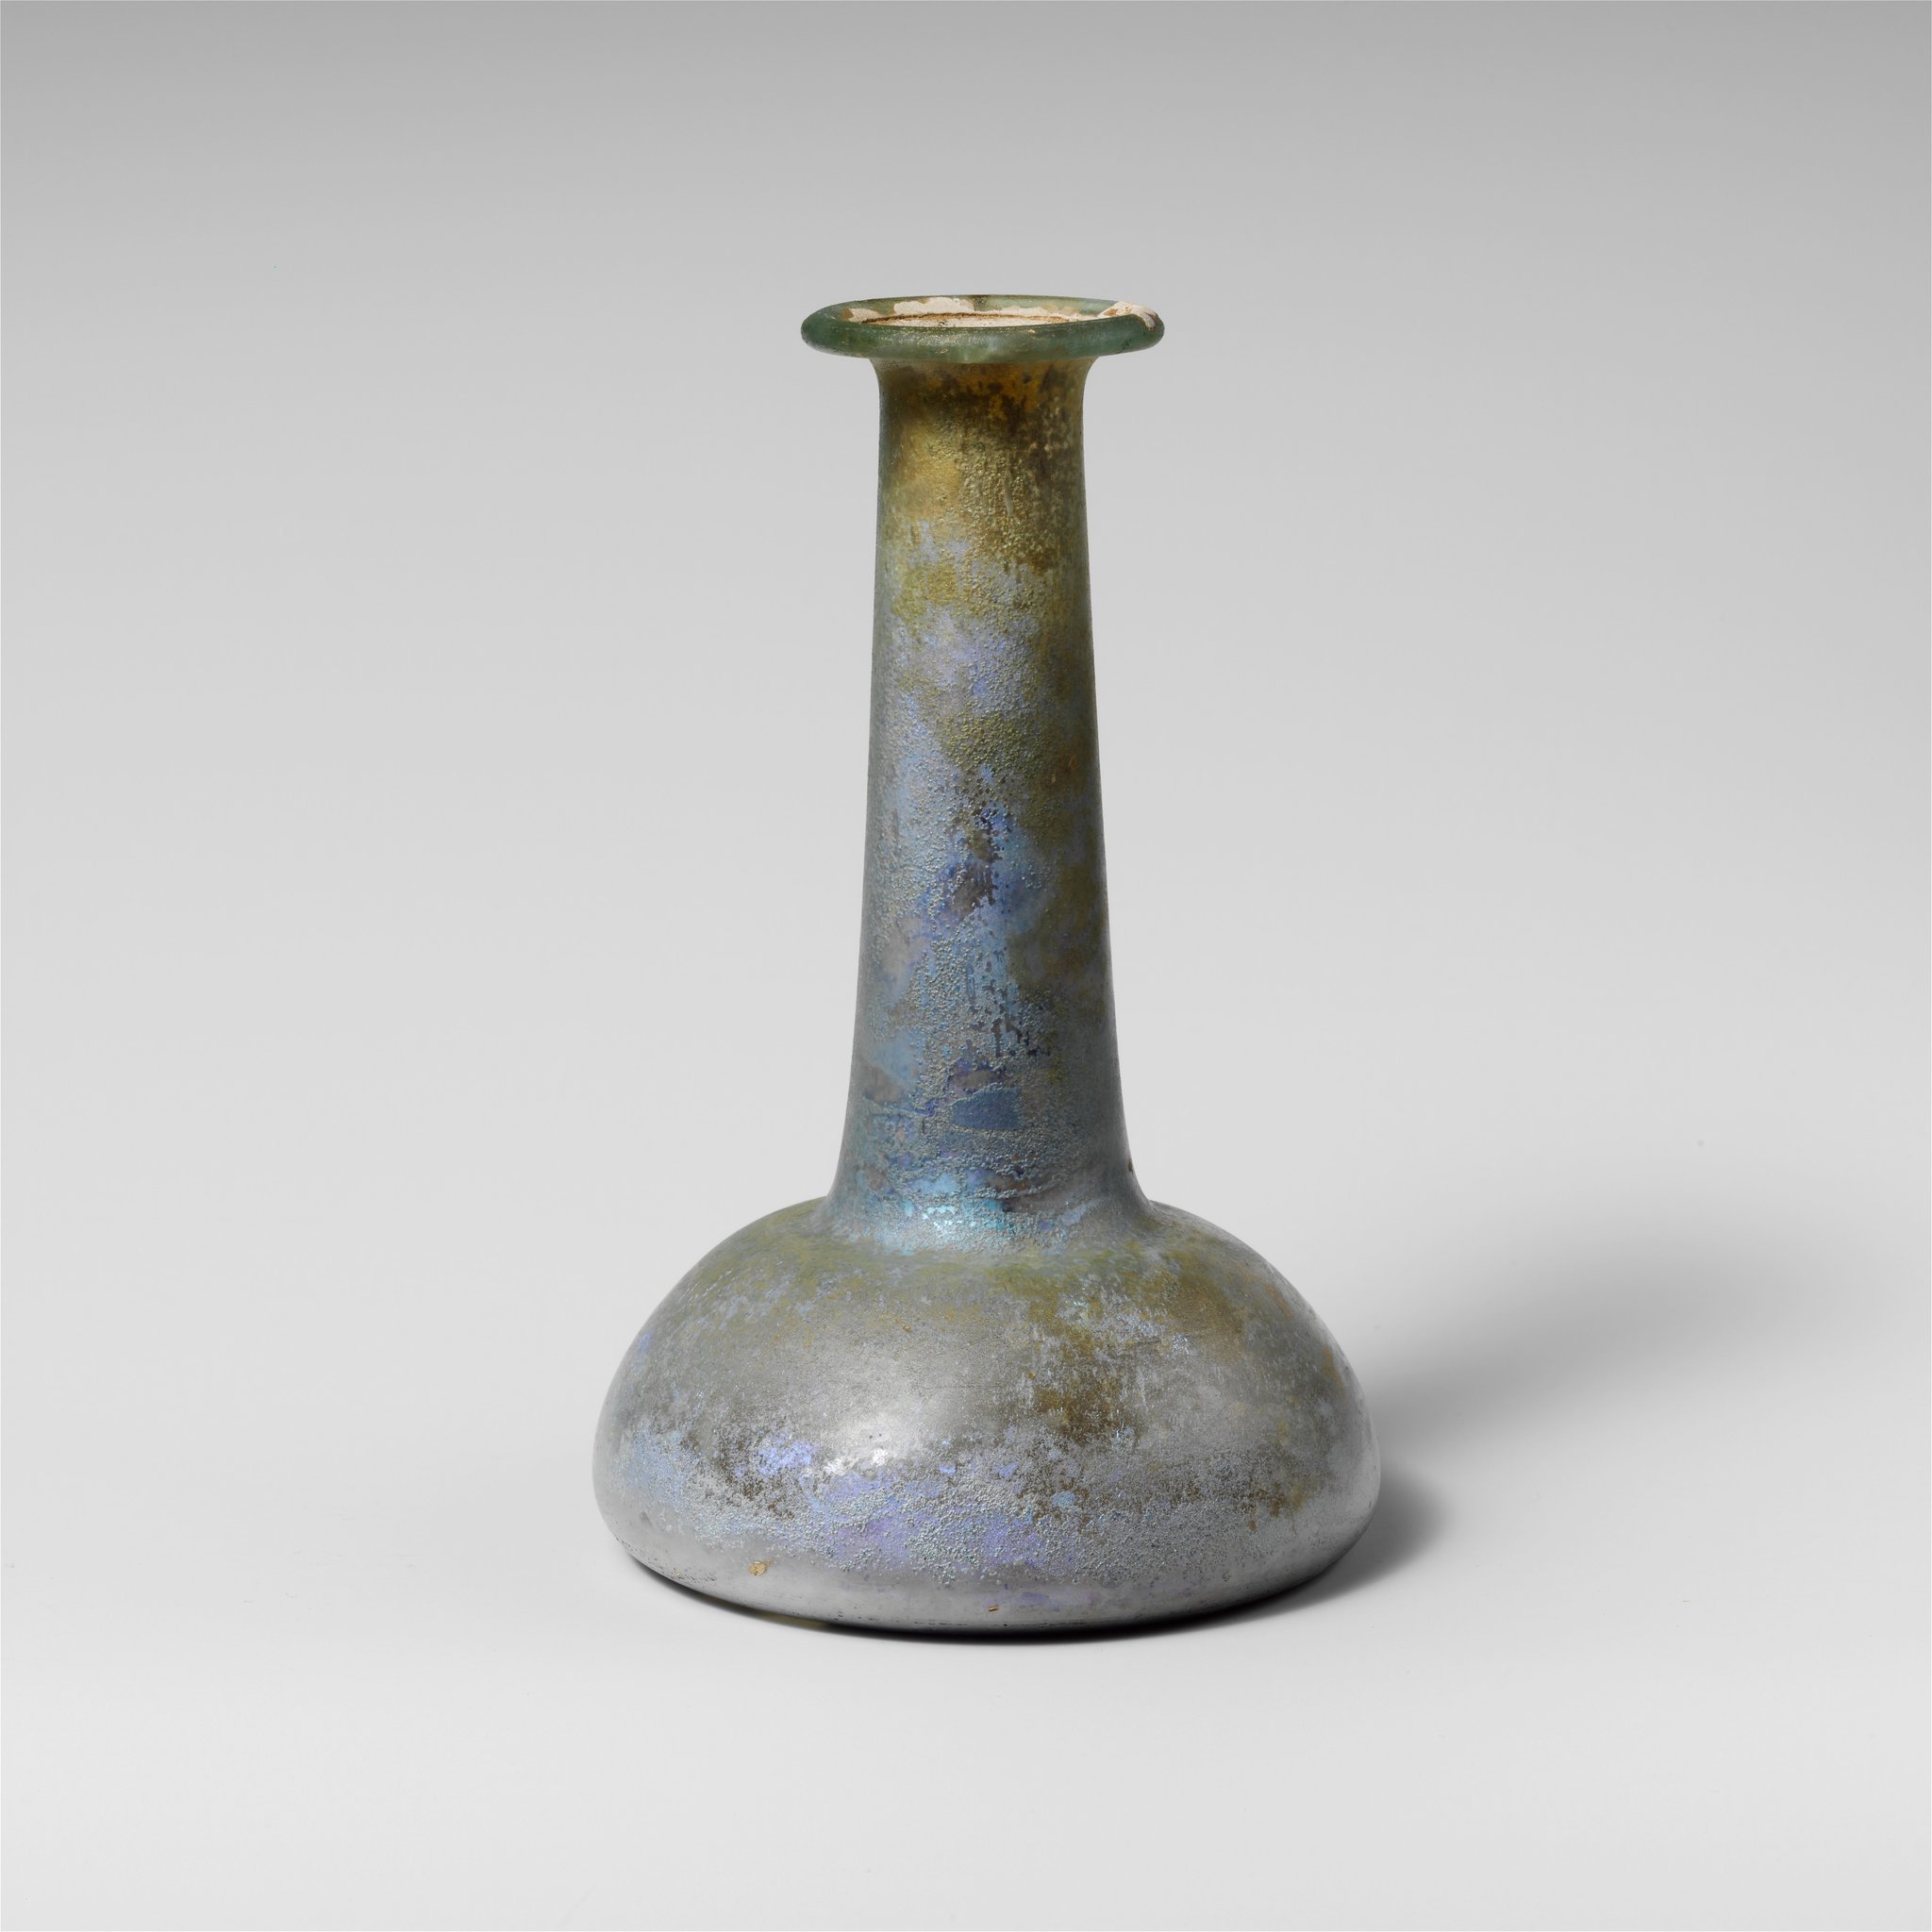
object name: perfume bottle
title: Glass perfume bottle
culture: roman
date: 101-300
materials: glass